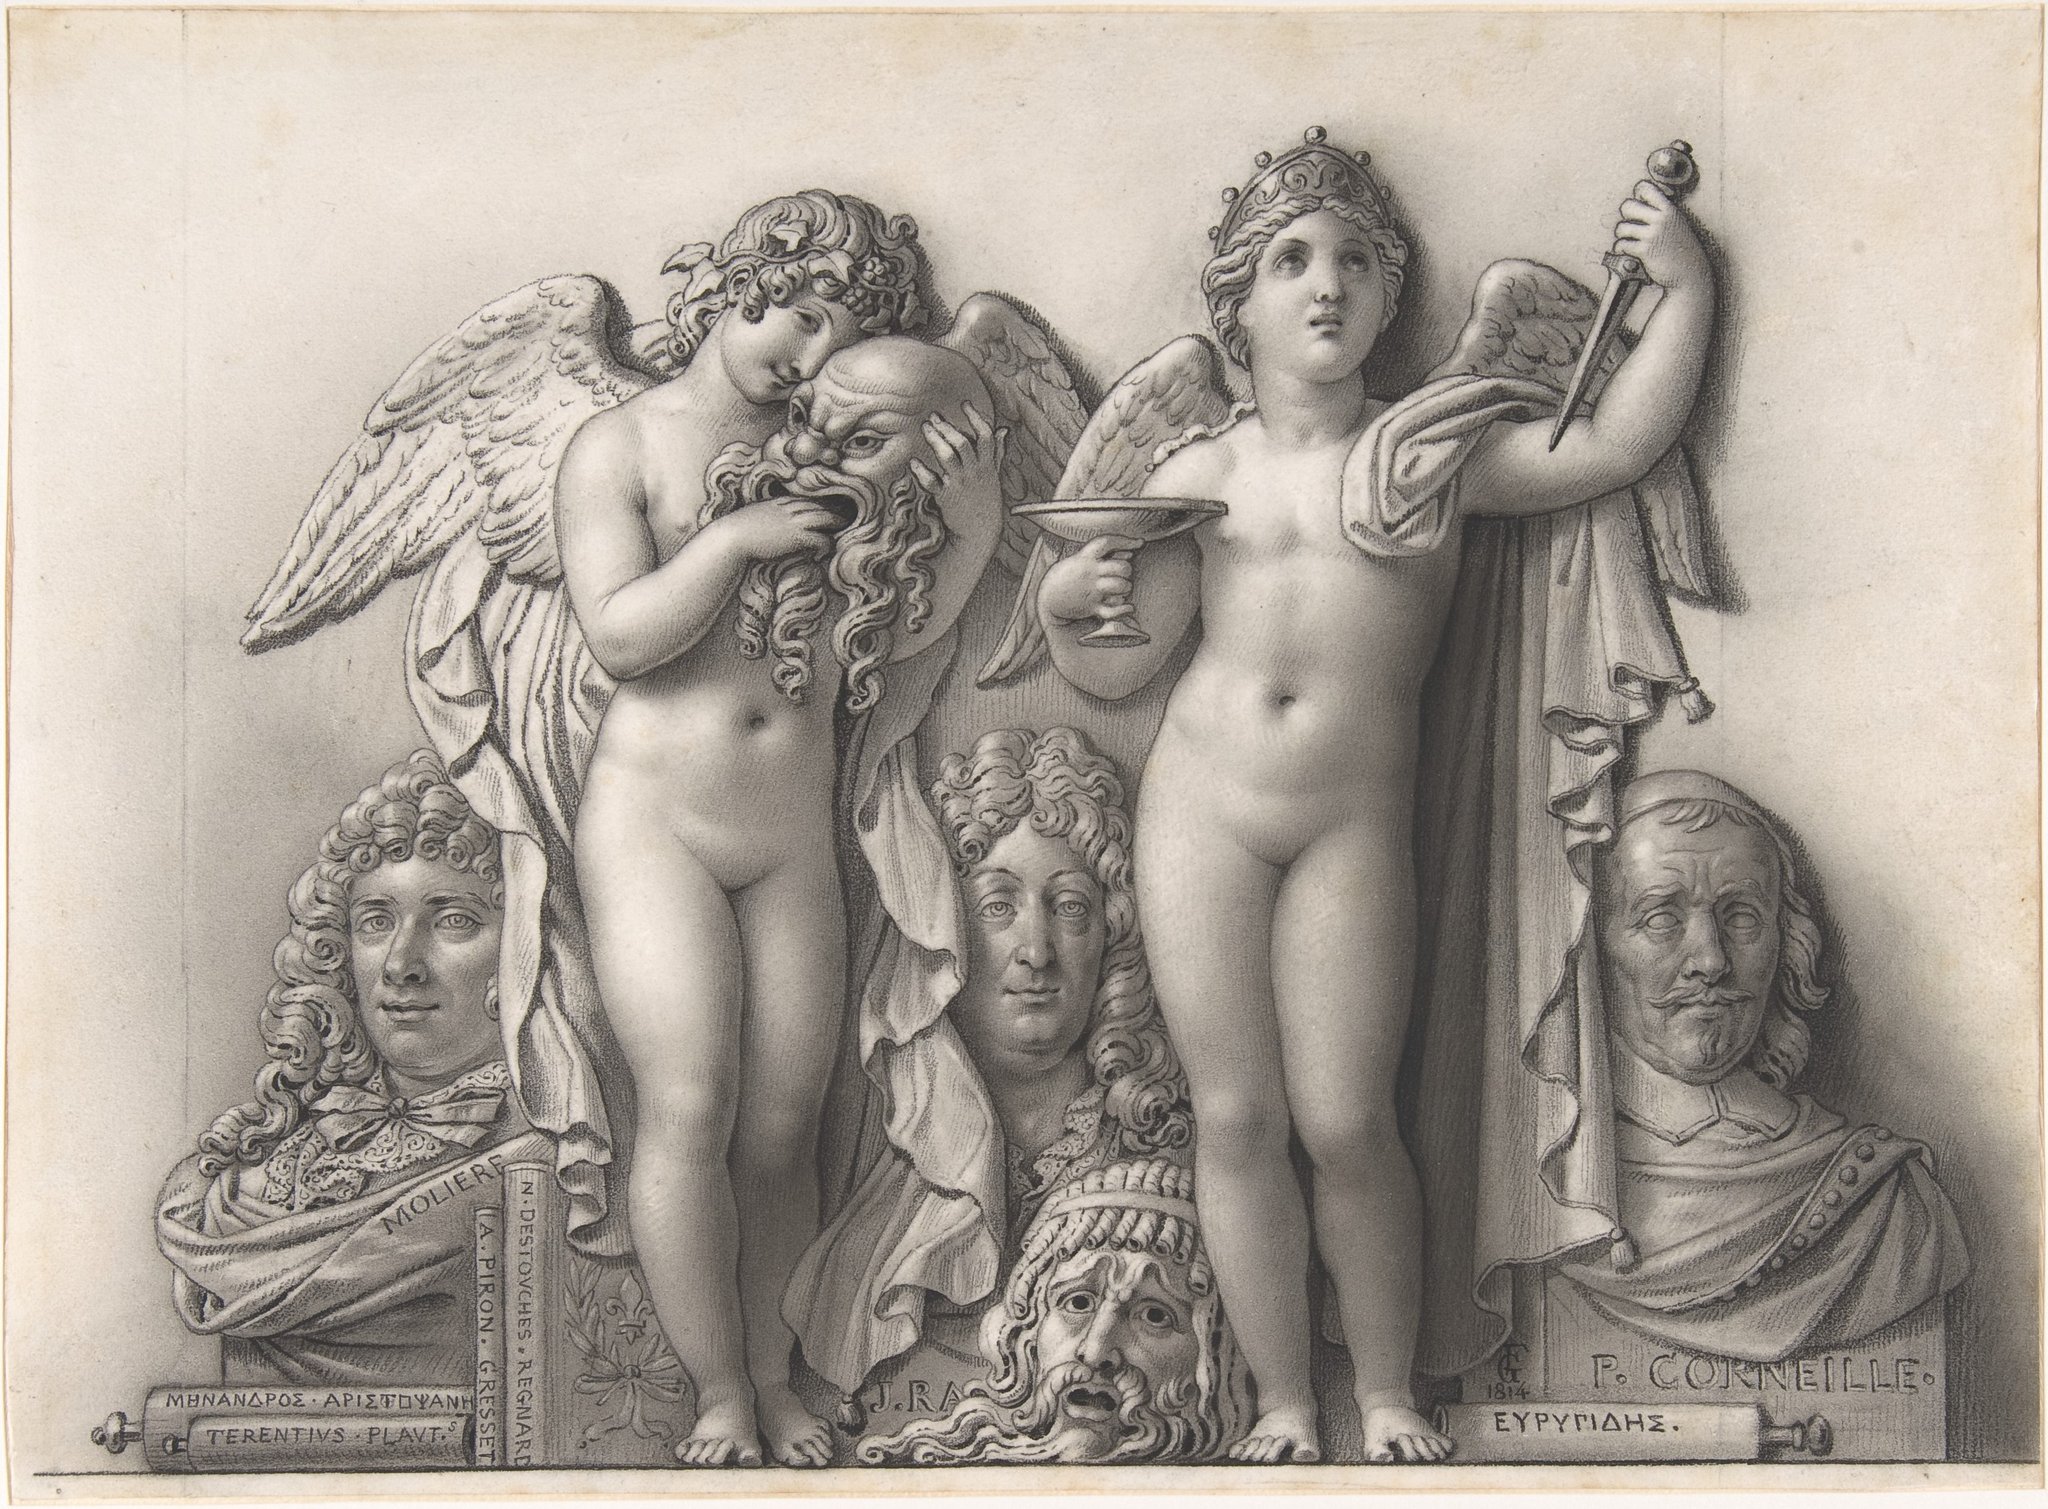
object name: drawing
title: Comedy and Tragedy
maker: anne louis girodet-trioson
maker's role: artist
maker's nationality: french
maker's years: 1767-1824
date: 1814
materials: chalk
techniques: stumping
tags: weapons,heads,men